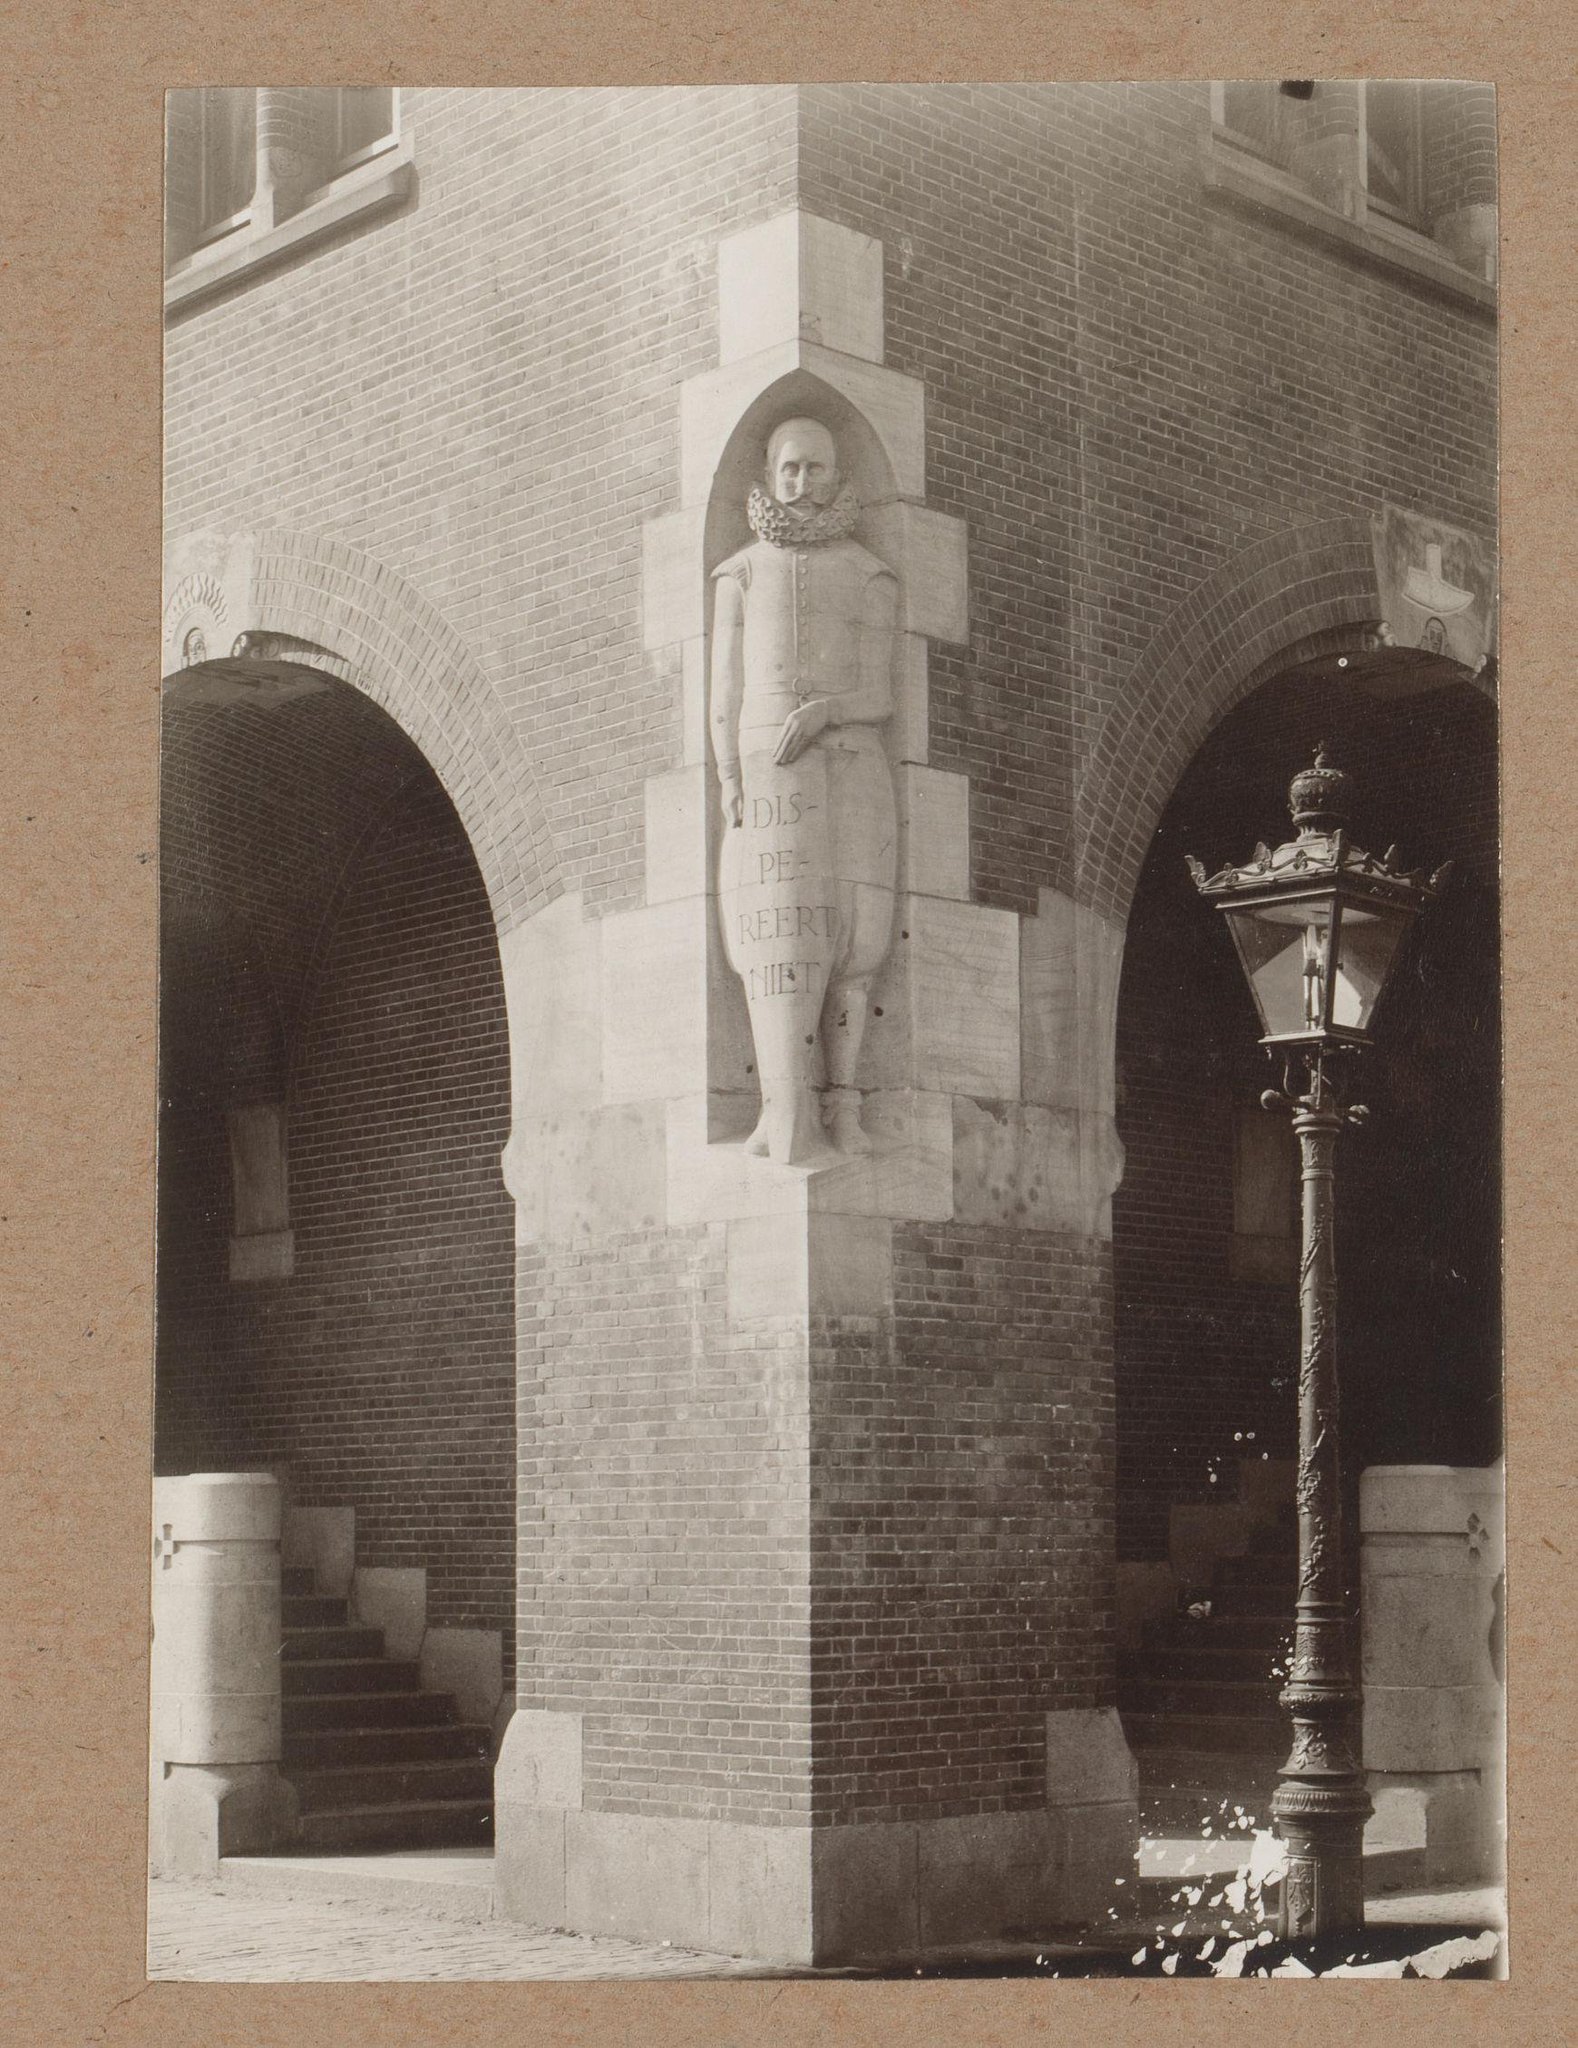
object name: photograph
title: Sculptuur van Jan Pietersz. Coen bij de ingang aan het Damrak van de Beurs van Berlage te Amsterdam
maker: Anonymous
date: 1903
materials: paper, cardboard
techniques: gelatin silver print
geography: amsterdam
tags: batavia, piece of sculpture, reproduction of a piece of sculpture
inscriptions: stamp: ‘Rijksmuseum/ Amsterdam’